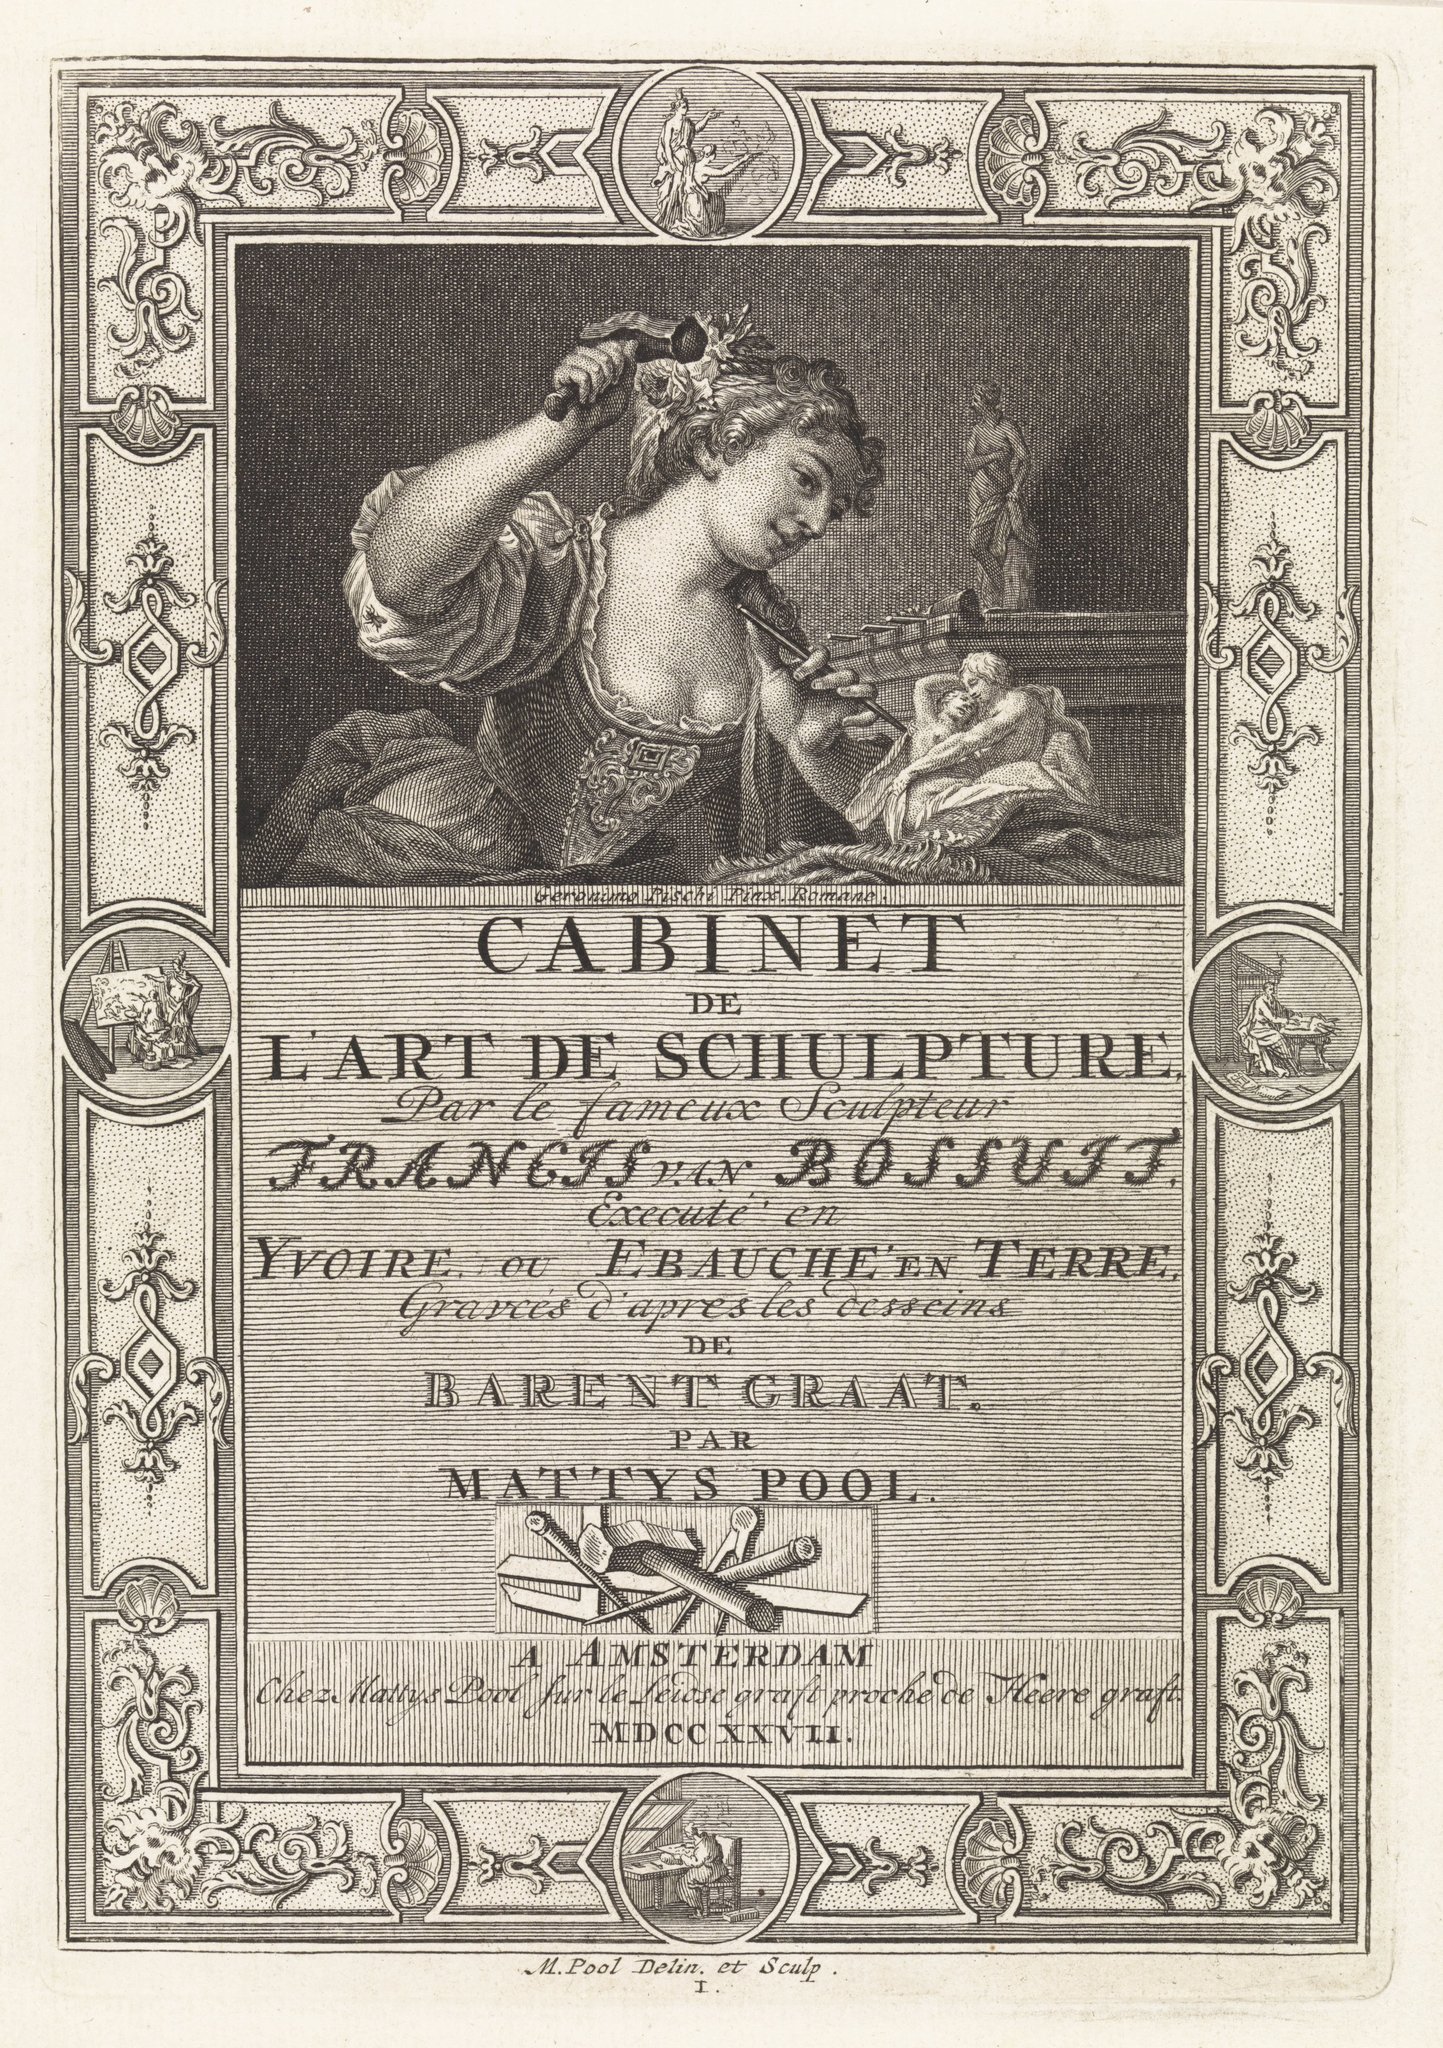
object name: print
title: Titelpagina met verwijzingen naar de kunsten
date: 1727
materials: paper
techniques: engraving, etching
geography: amsterdam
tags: auricular ornament, lobe style ~ ornament, sculptor at work, 'pictura', symbolic representations, allegories and emblems ~ painting; 'pittura' (ripa), 'sculptura', symbolic representations, allegories and emblems ~ sculpture; 'scoltura' (ripa), 'architectura', symbolic representations, allegories and emblems ~ architecture; 'architettura' (ripa), symbolic representations, allegories and emblems ~ drawing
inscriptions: collector's mark: Lugt 2228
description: Ornamentele omlijsting met vier medaillons waarin de tekenkunst, architectuur, beeldhouwkunst en schilderkunst zijn voorgesteld. Bovenaan een dame die bezig is met beeldhouwen. Onder de voorstelling de titel in het Frans. Midden onder genummerd: I.